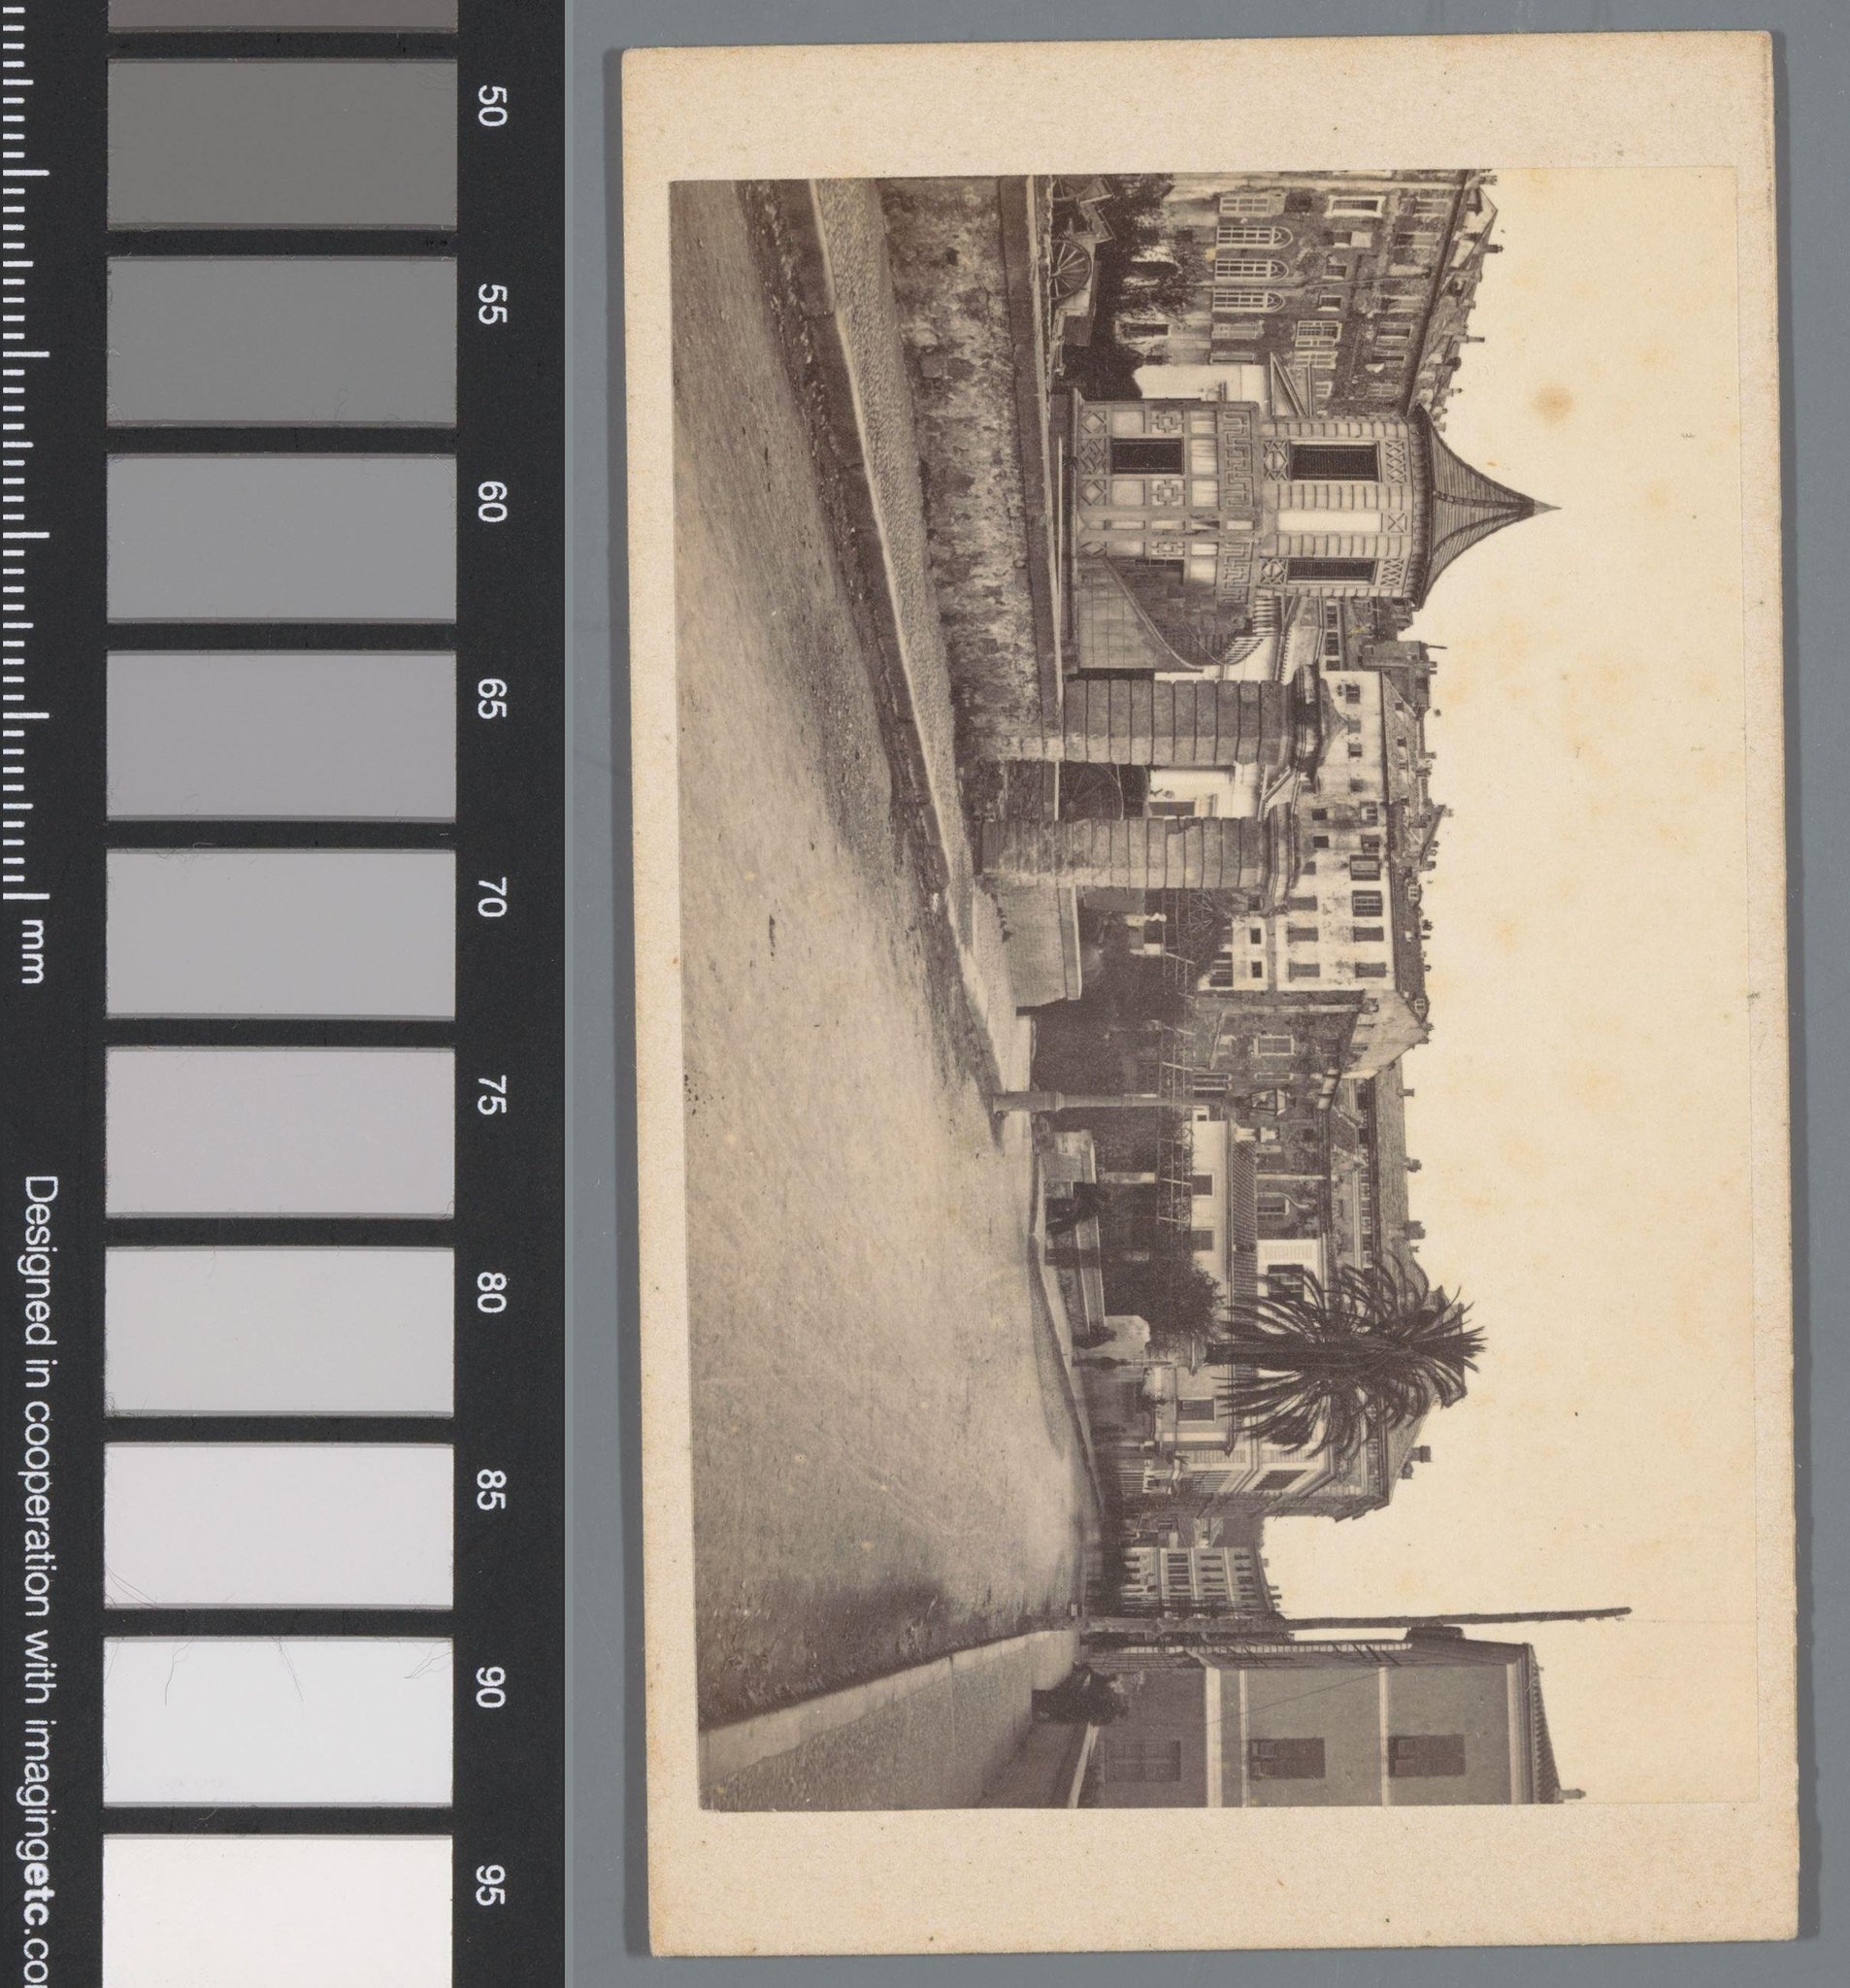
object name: carte de visite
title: Straat in San Remo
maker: celestino degoix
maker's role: fotograaf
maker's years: 1825-1902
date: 1860-1890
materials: cardboard, paper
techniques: albumen print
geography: san remo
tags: street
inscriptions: inscription: ‘C. Degoix/ fotografo/ brevettato/ da S.M. il Re d'Italia/ Via Carlo Felice/ No. 10/ Genova/ N. 381./ C. Degoix - Fotografo a Genova’